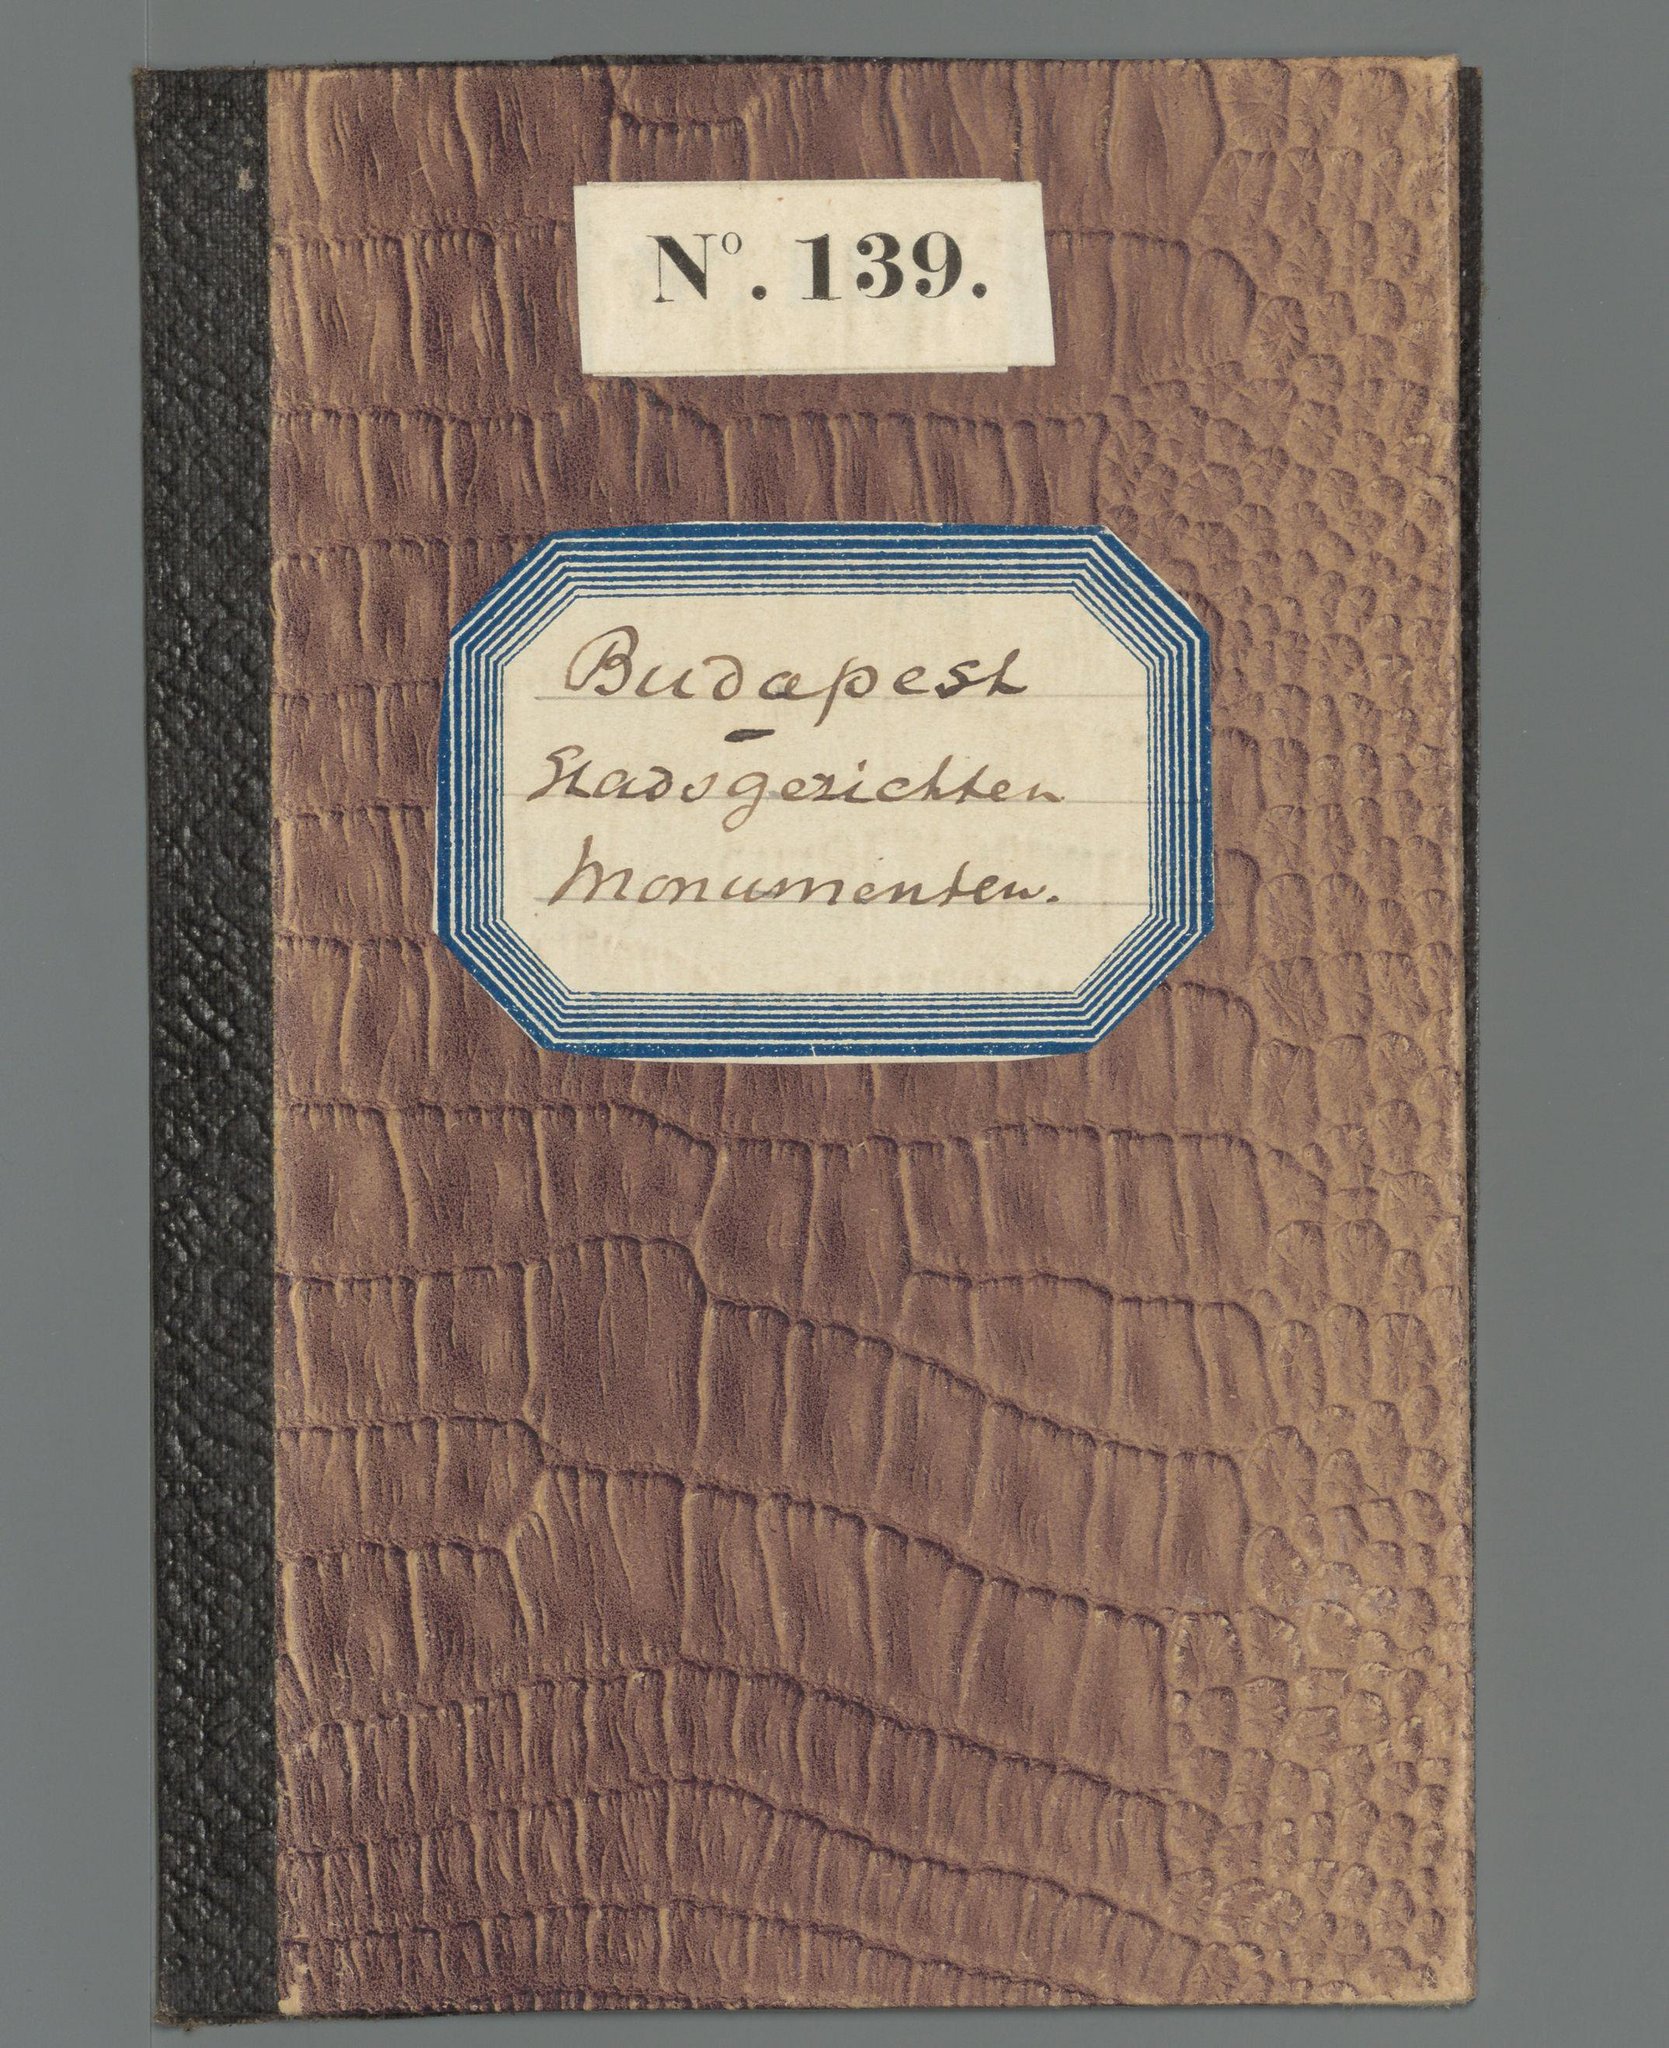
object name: wrapper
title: Budapest. Stadsgezichten. Monumenten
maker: Anonymous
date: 1900-1950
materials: cardboard, paper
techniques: lithograph, writing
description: In de omslag zit een kaart ingestoken met daarop een korte beschrijving van de inhoud.